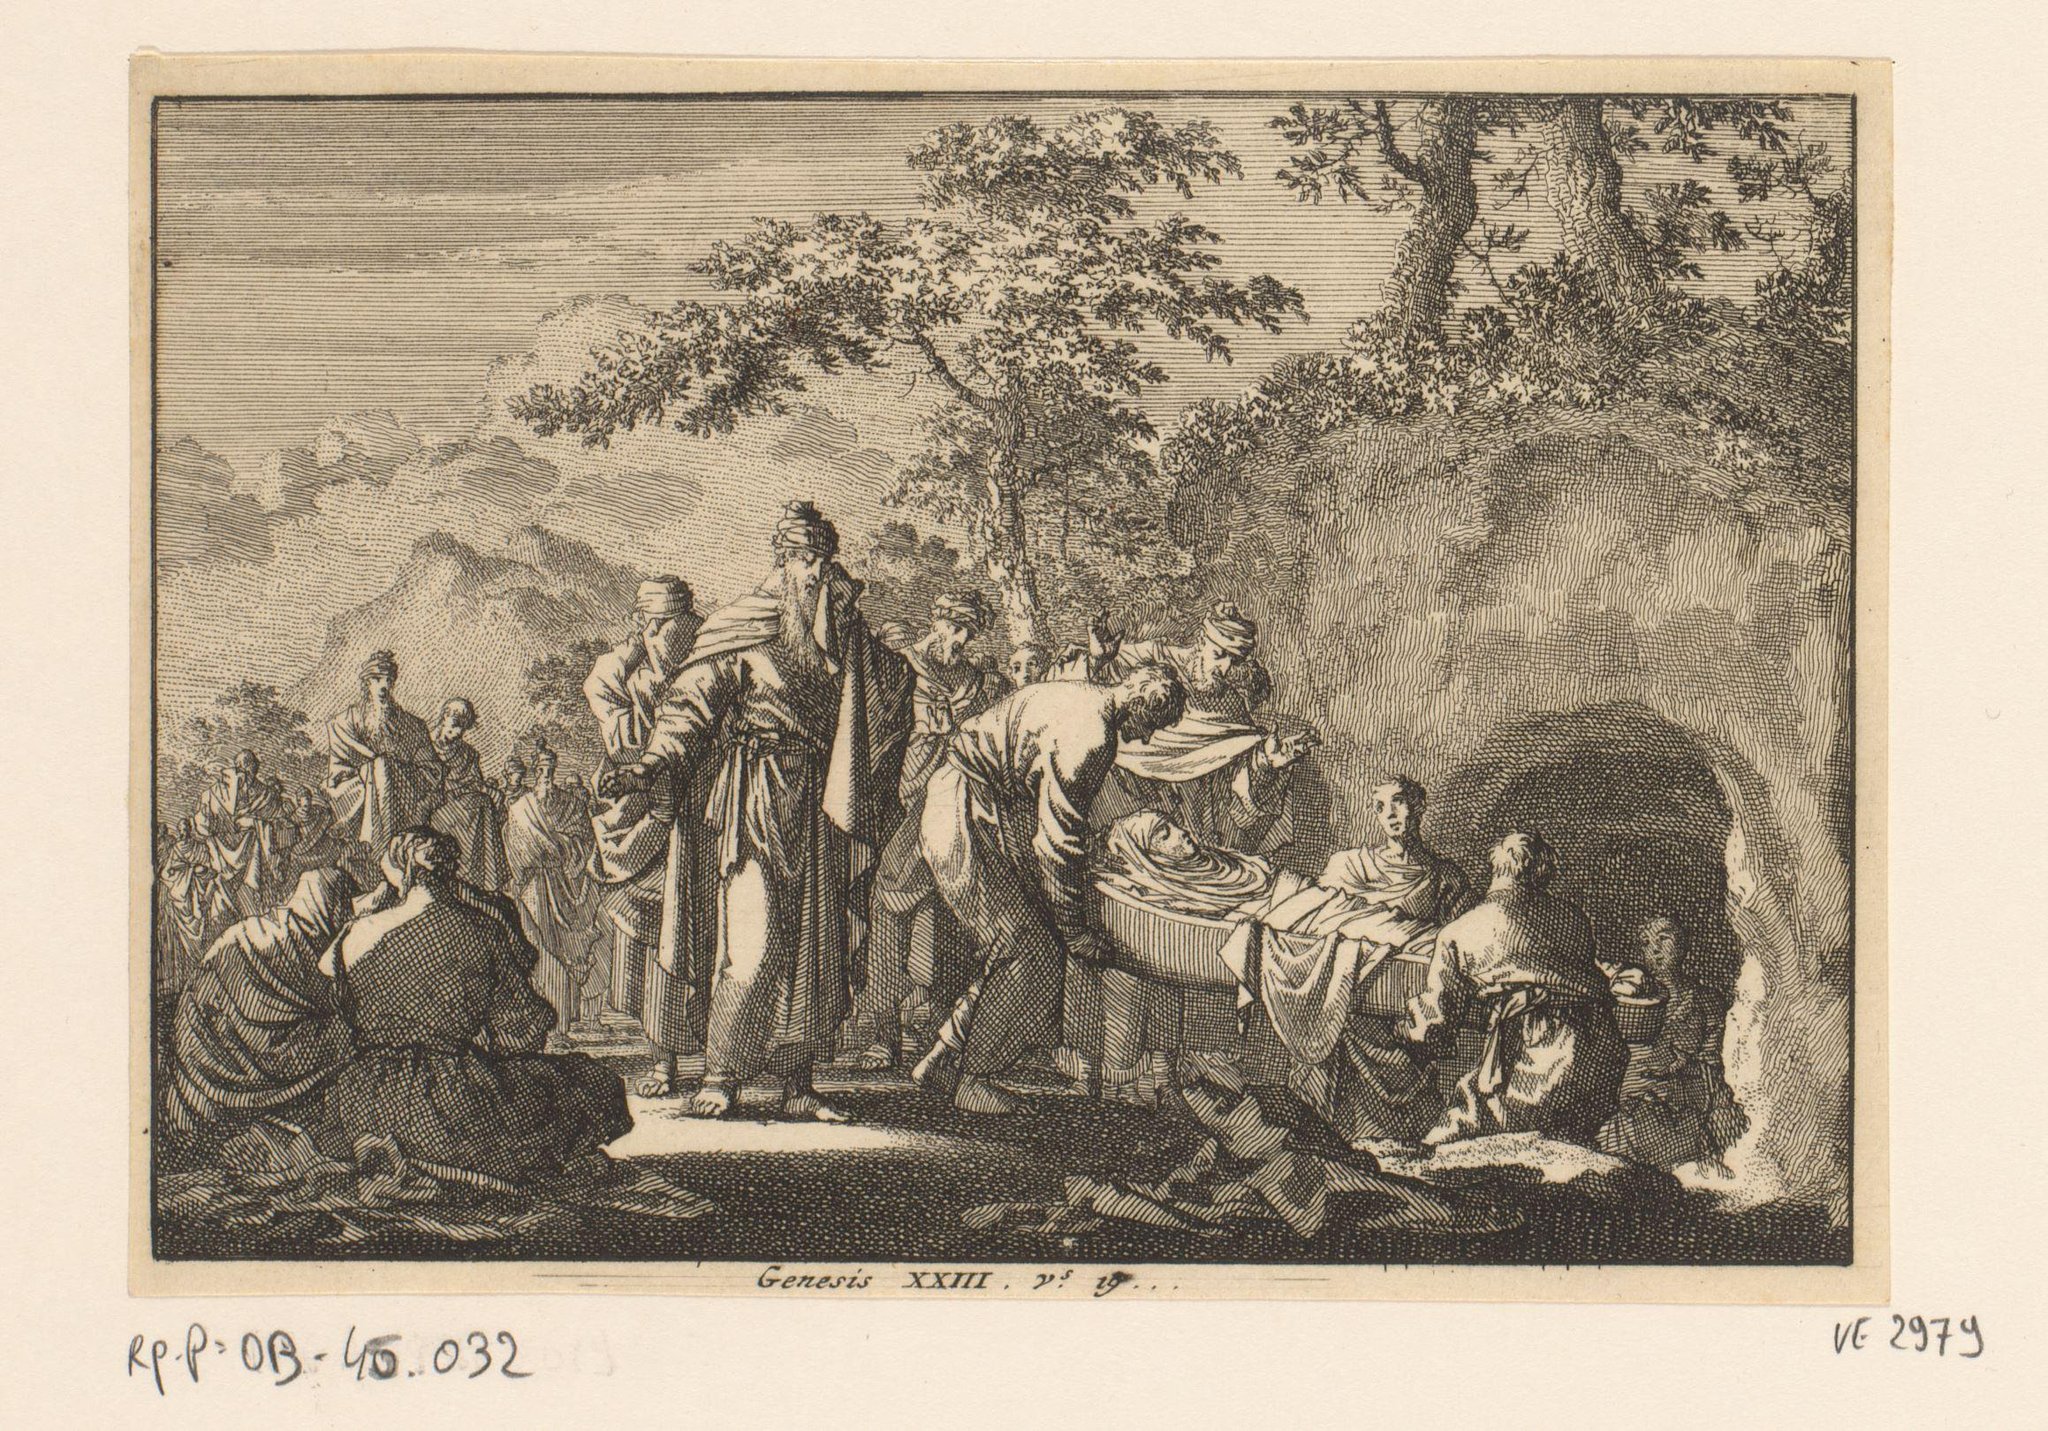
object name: print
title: Begrafenis van Sara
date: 1703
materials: paper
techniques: etching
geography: amsterdam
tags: sarah's burial in the cave of machpelah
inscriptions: collector's mark: Lugt 2228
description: Proefdruk van een boekillustratie voor David Martin. Historie des Ouden en Nieuwen Testaments. Amsterdam, Pieter Mortier, 1703. Deel I. De boekillustraties voor de Mortierbijbel hebben verschillende staten en kopieën, waarbij de chronologische volgorde moeilijk te achterhalen valt. Als boekillustraties werden ze bovendien herhaaldelijk opnieuw gebruikt voor andere boekwerken.